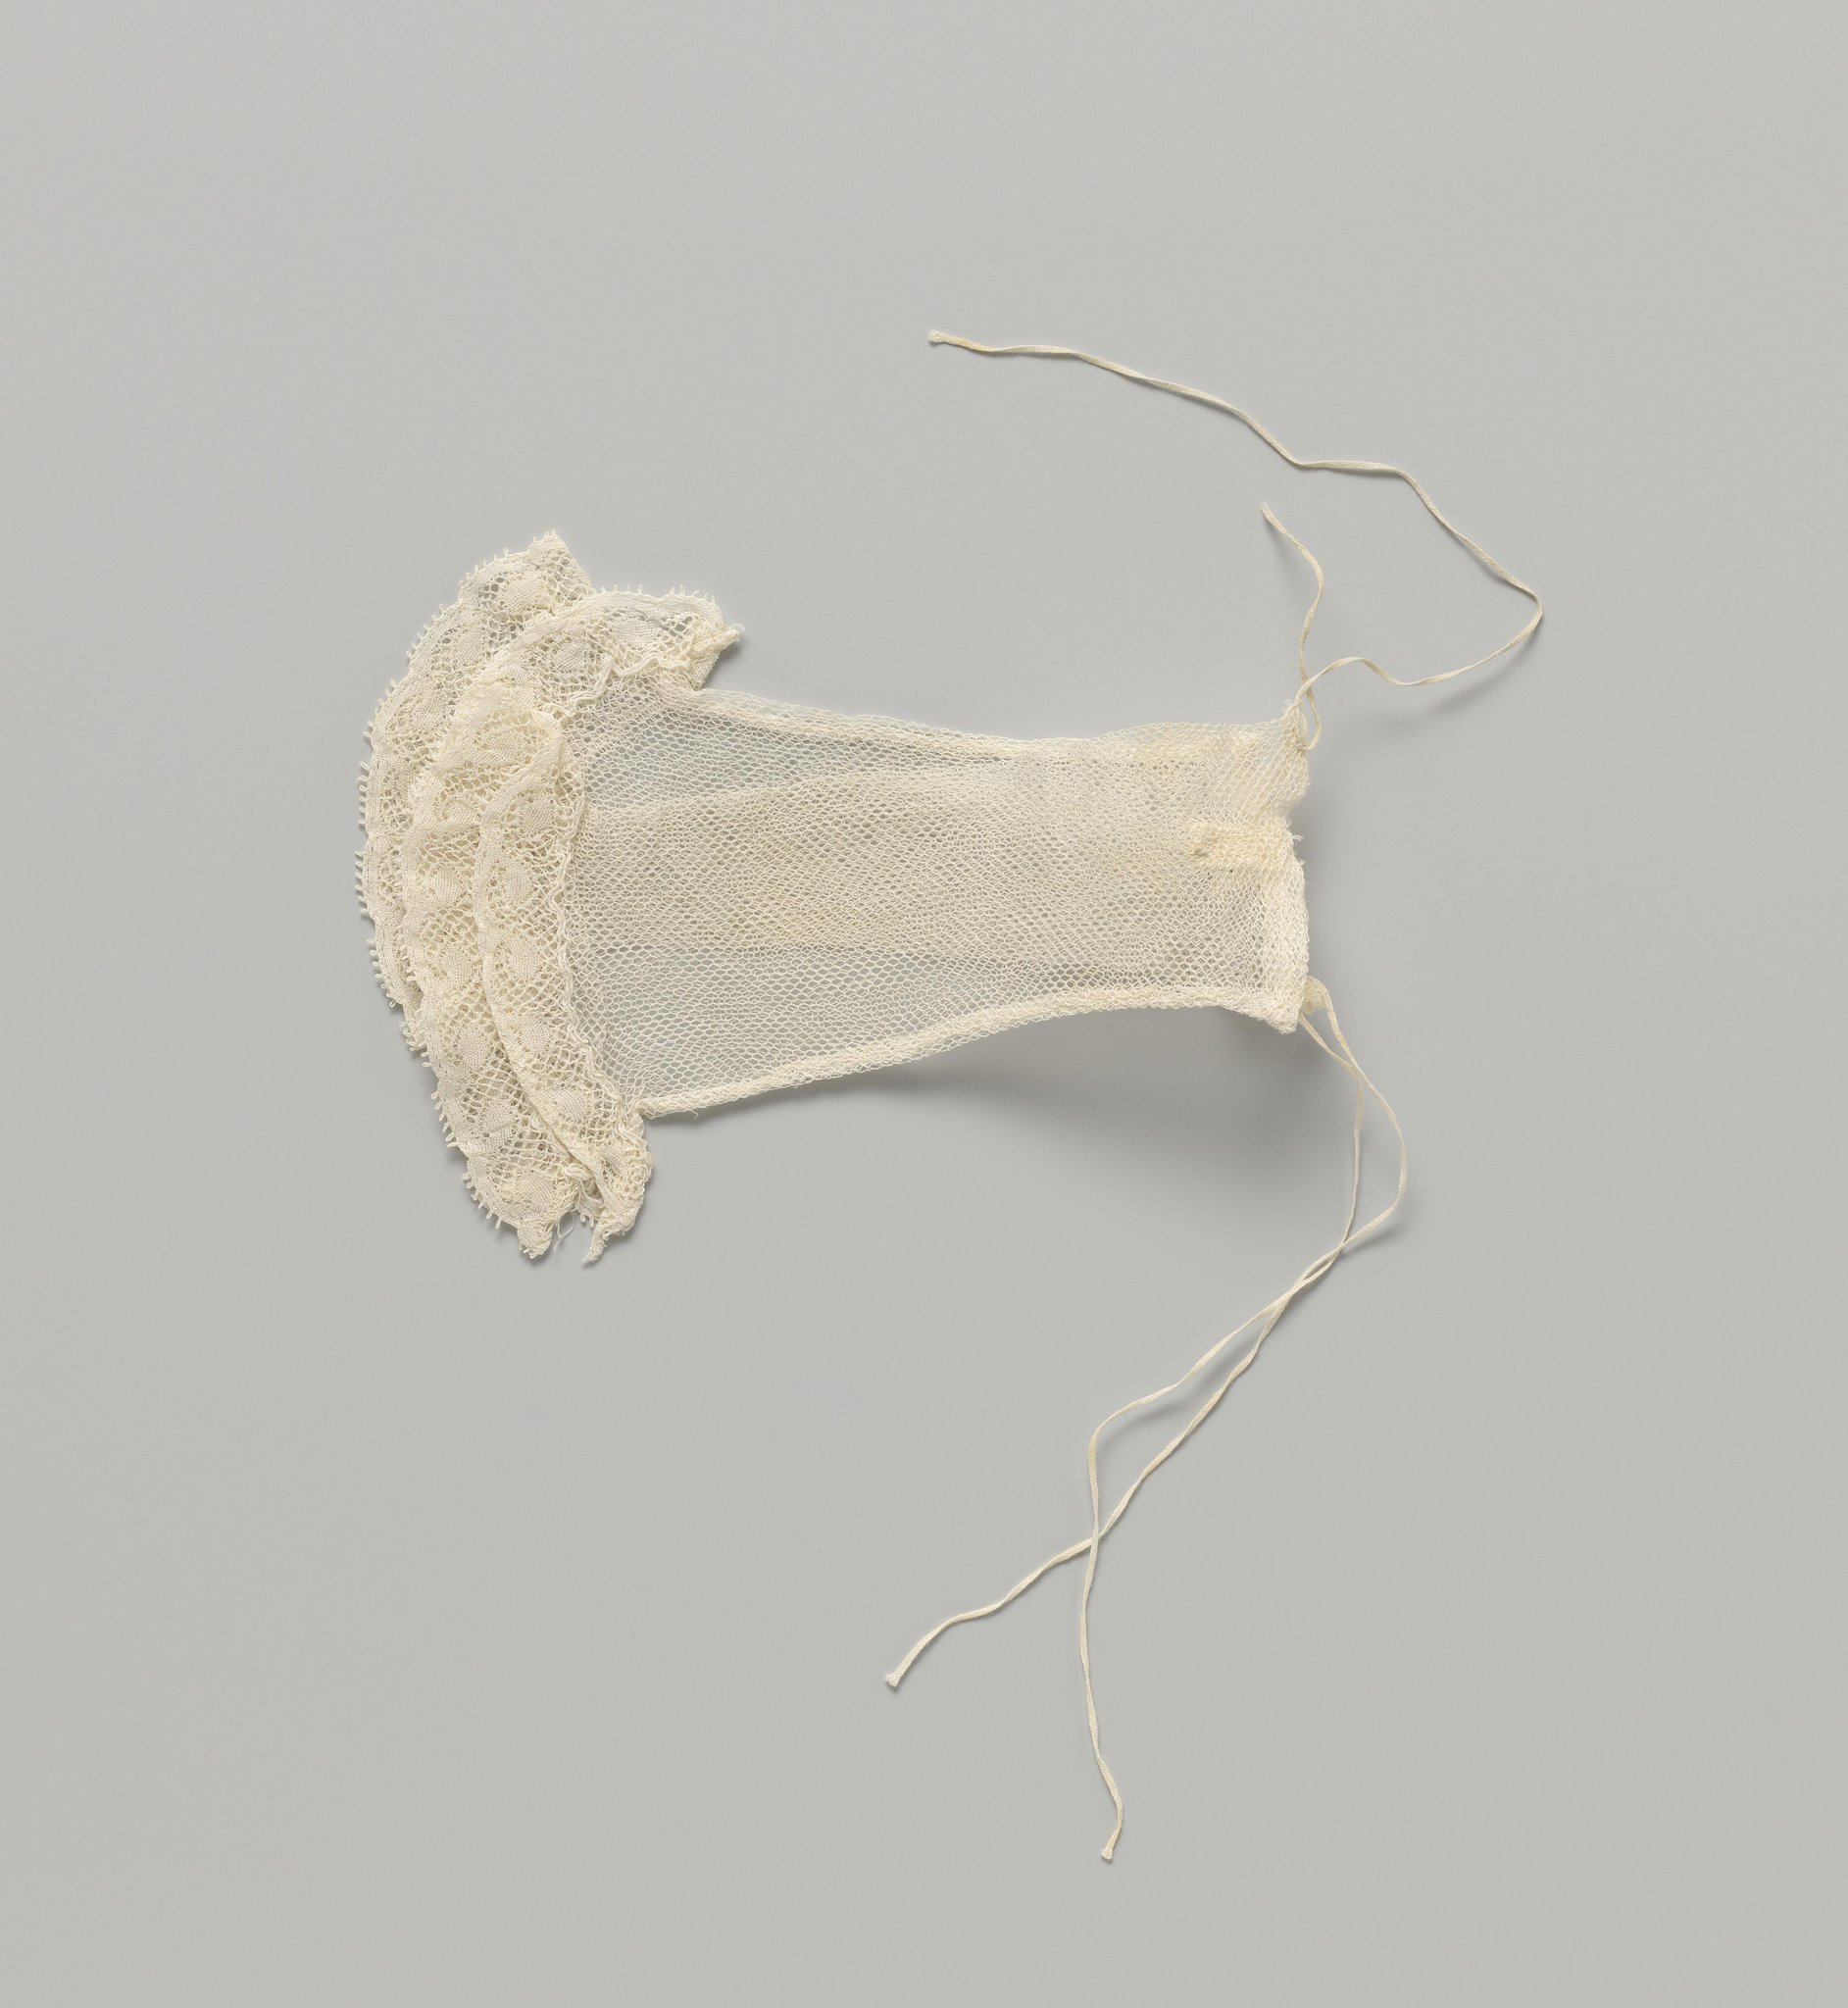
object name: doll's clothing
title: Witte mouwen van kant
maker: Anonymous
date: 1850-1920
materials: textile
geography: netherlands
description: De mouwen zijn met een label aneen genaaid.